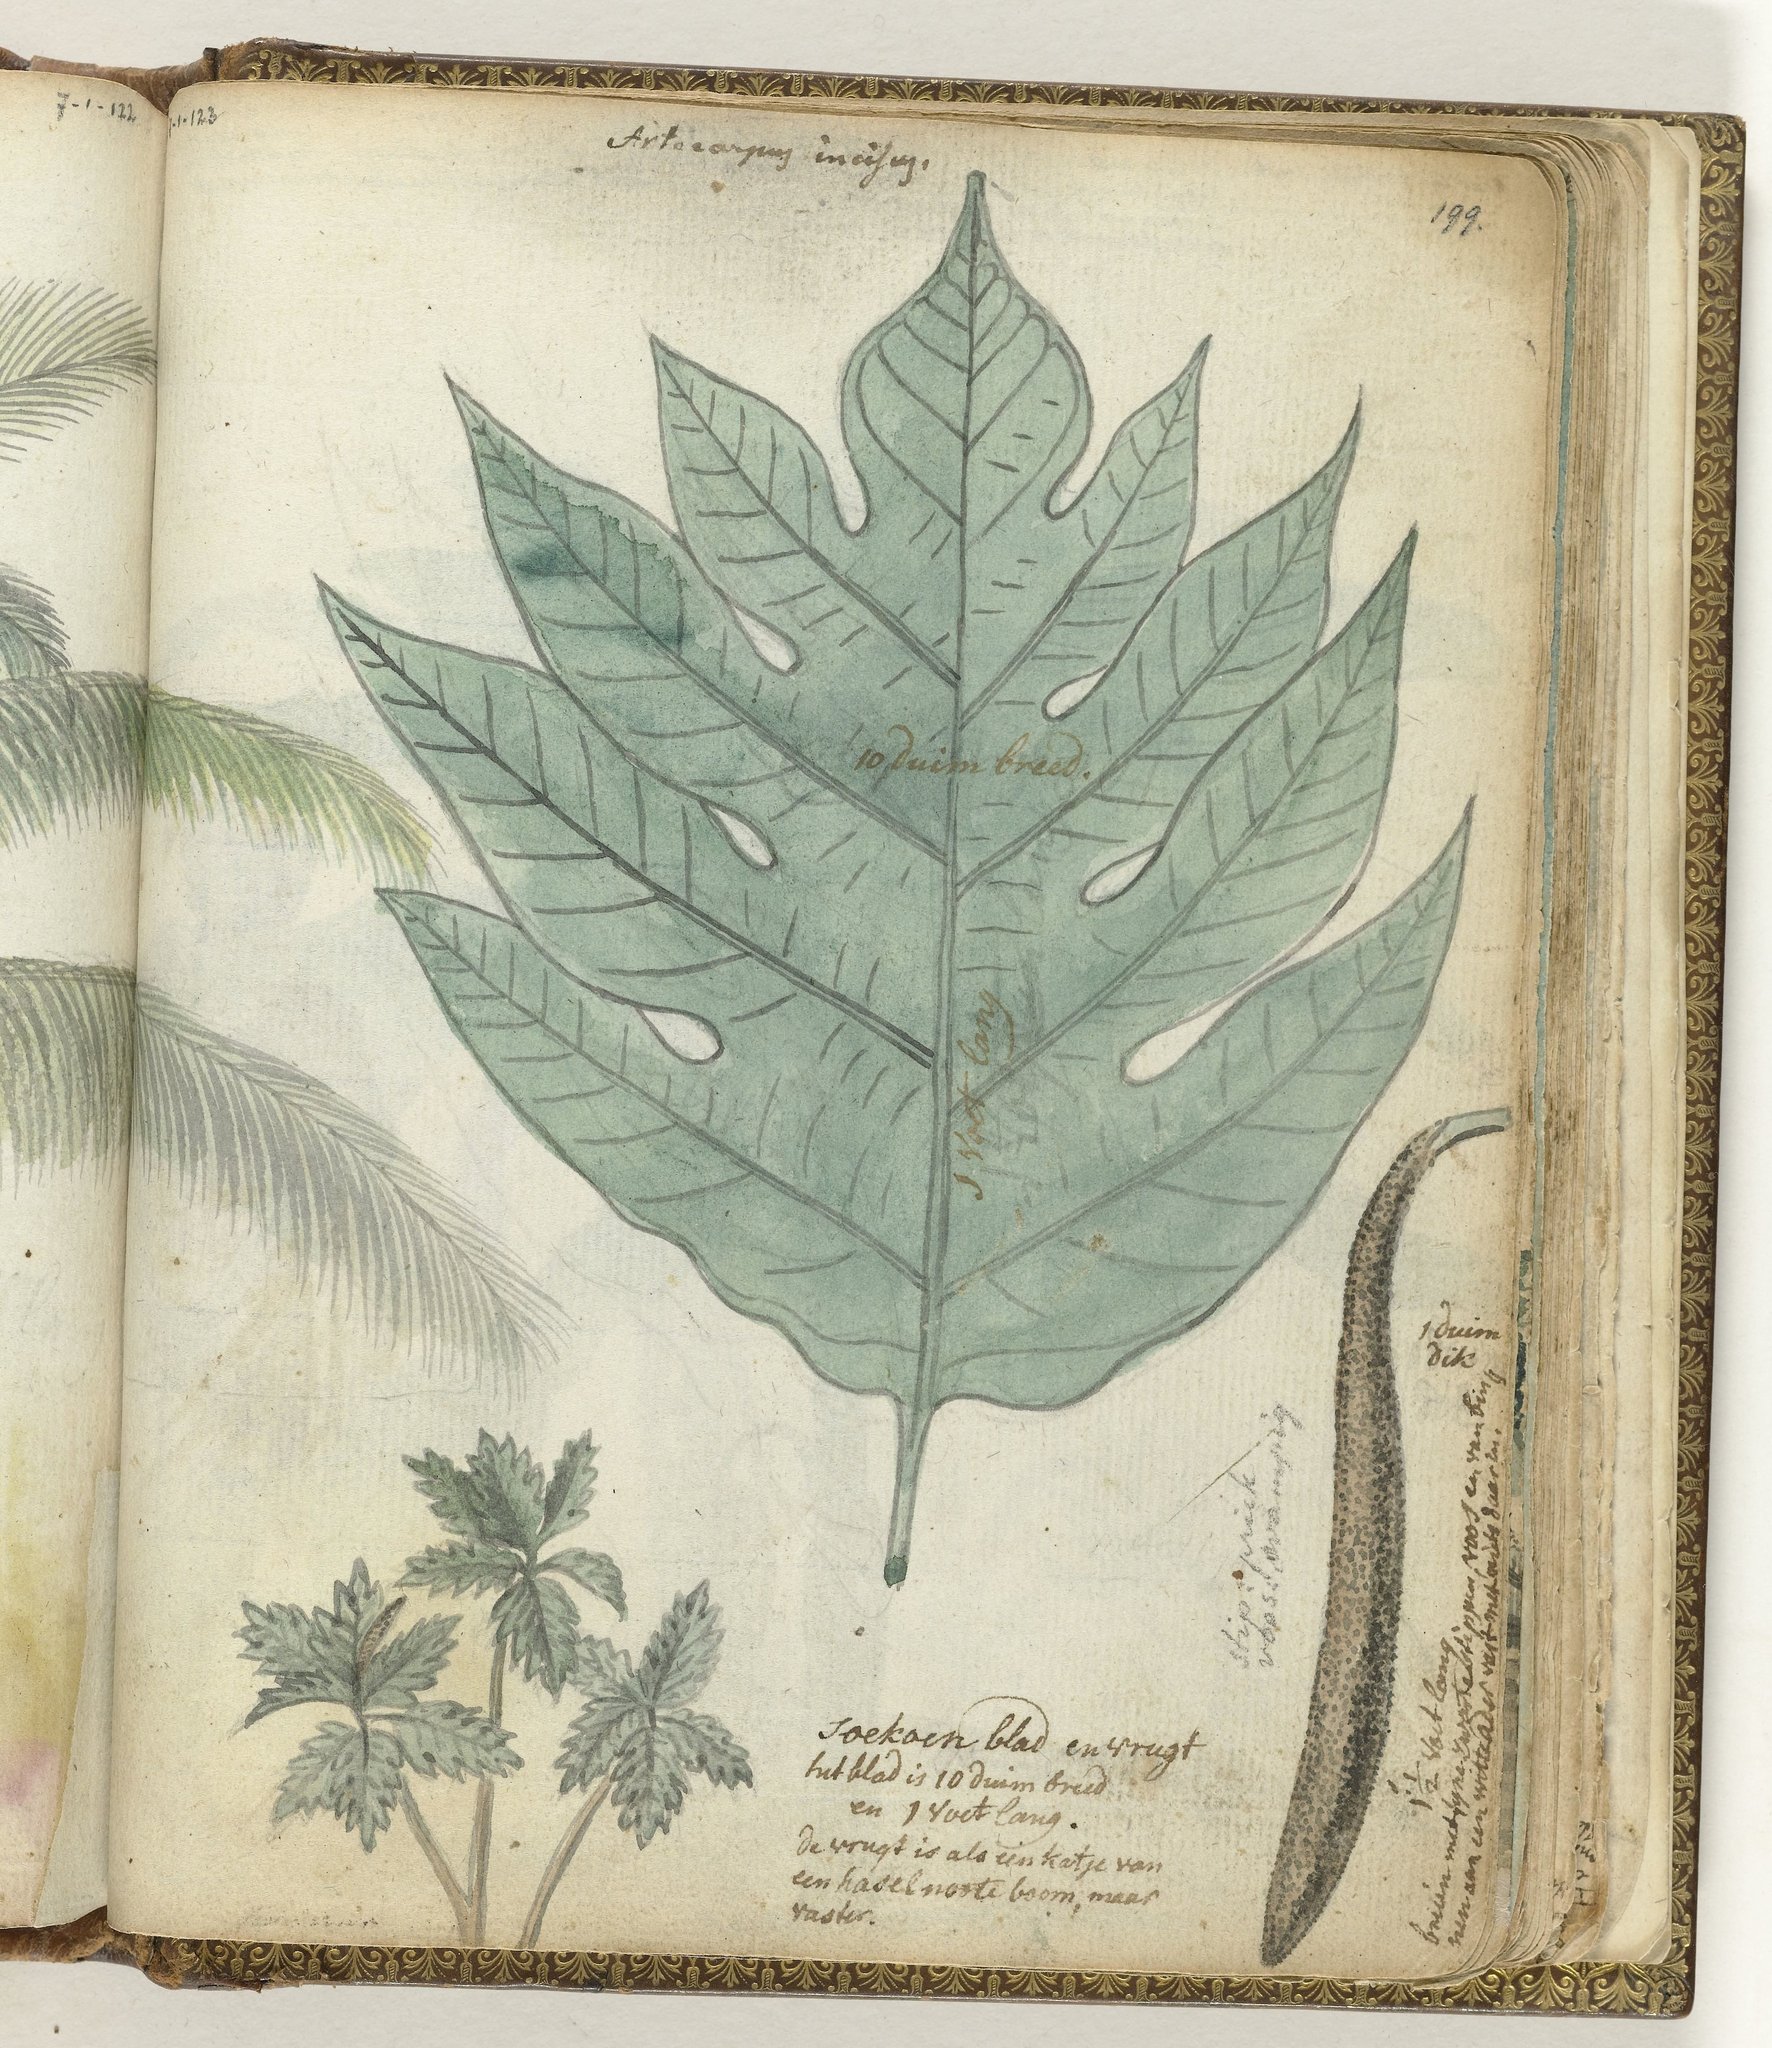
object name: drawing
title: Soekoenblad en vrucht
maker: jan brandes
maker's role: draughtsman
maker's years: 1743-1808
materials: paper, pencil, watercolor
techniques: brush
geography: jakarta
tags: plants (in general) (+ leaf), sri lanka, indonesia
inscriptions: inscription: ‘Artocarpus incisus.’, inscription: ‘Soekoen blad en vrugt het blad is 10 duim breed en 1 voet lang. De vrugt is als een katje van een haselnooteboom, maar vaster.’, inscription: ‘1½ voet lang. bruin met fyne zwarte stippen, voos en van binnen aan een witte ader vast met niets daarin.’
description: Kleurtekening van het blad, de vrucht en een tak van de soekoenboom. Met opschrift. Onderdeel uit het schetsboek van Jan Brandes, dl. 1 (1808), p. 199.